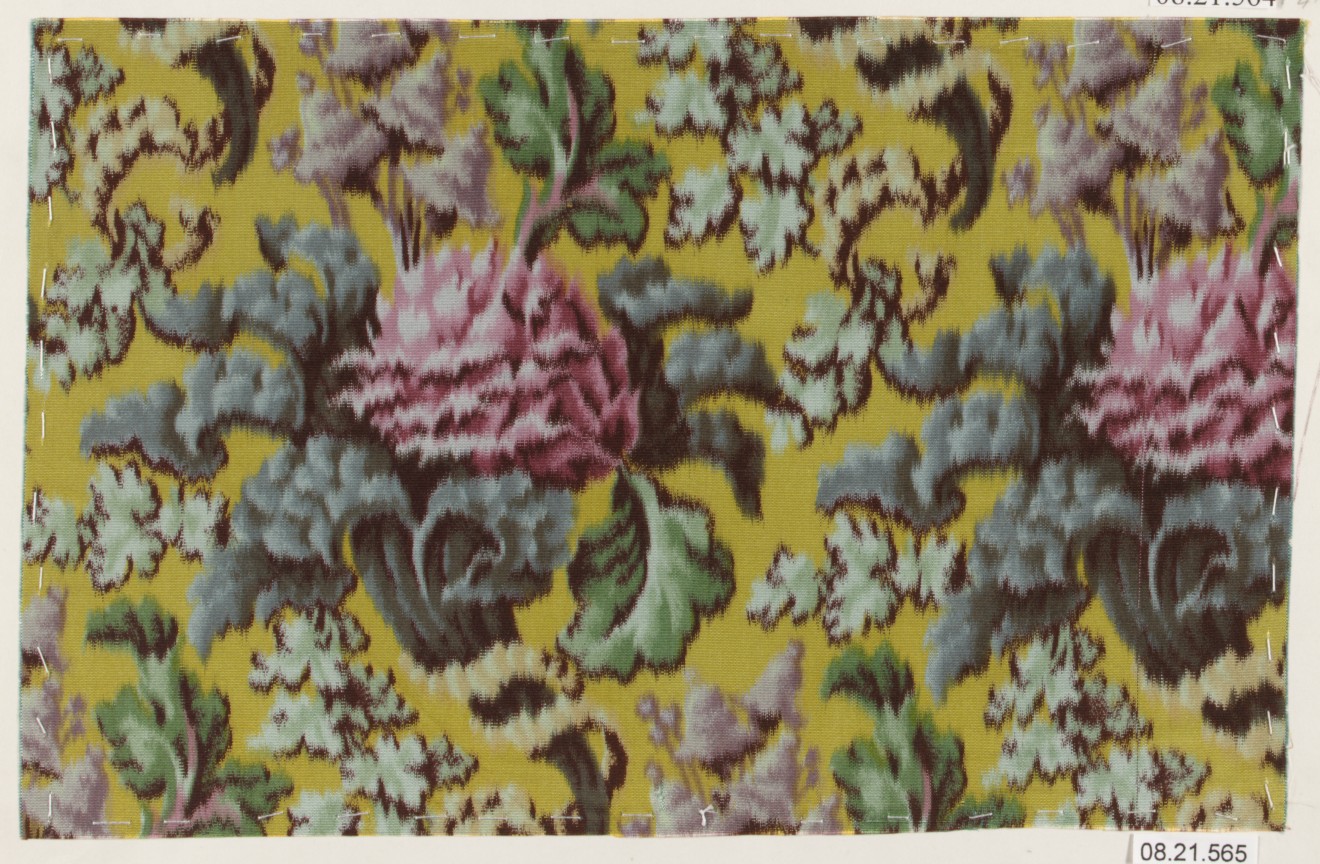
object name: textile sample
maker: Anonymous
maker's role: designer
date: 1900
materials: silk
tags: flowers